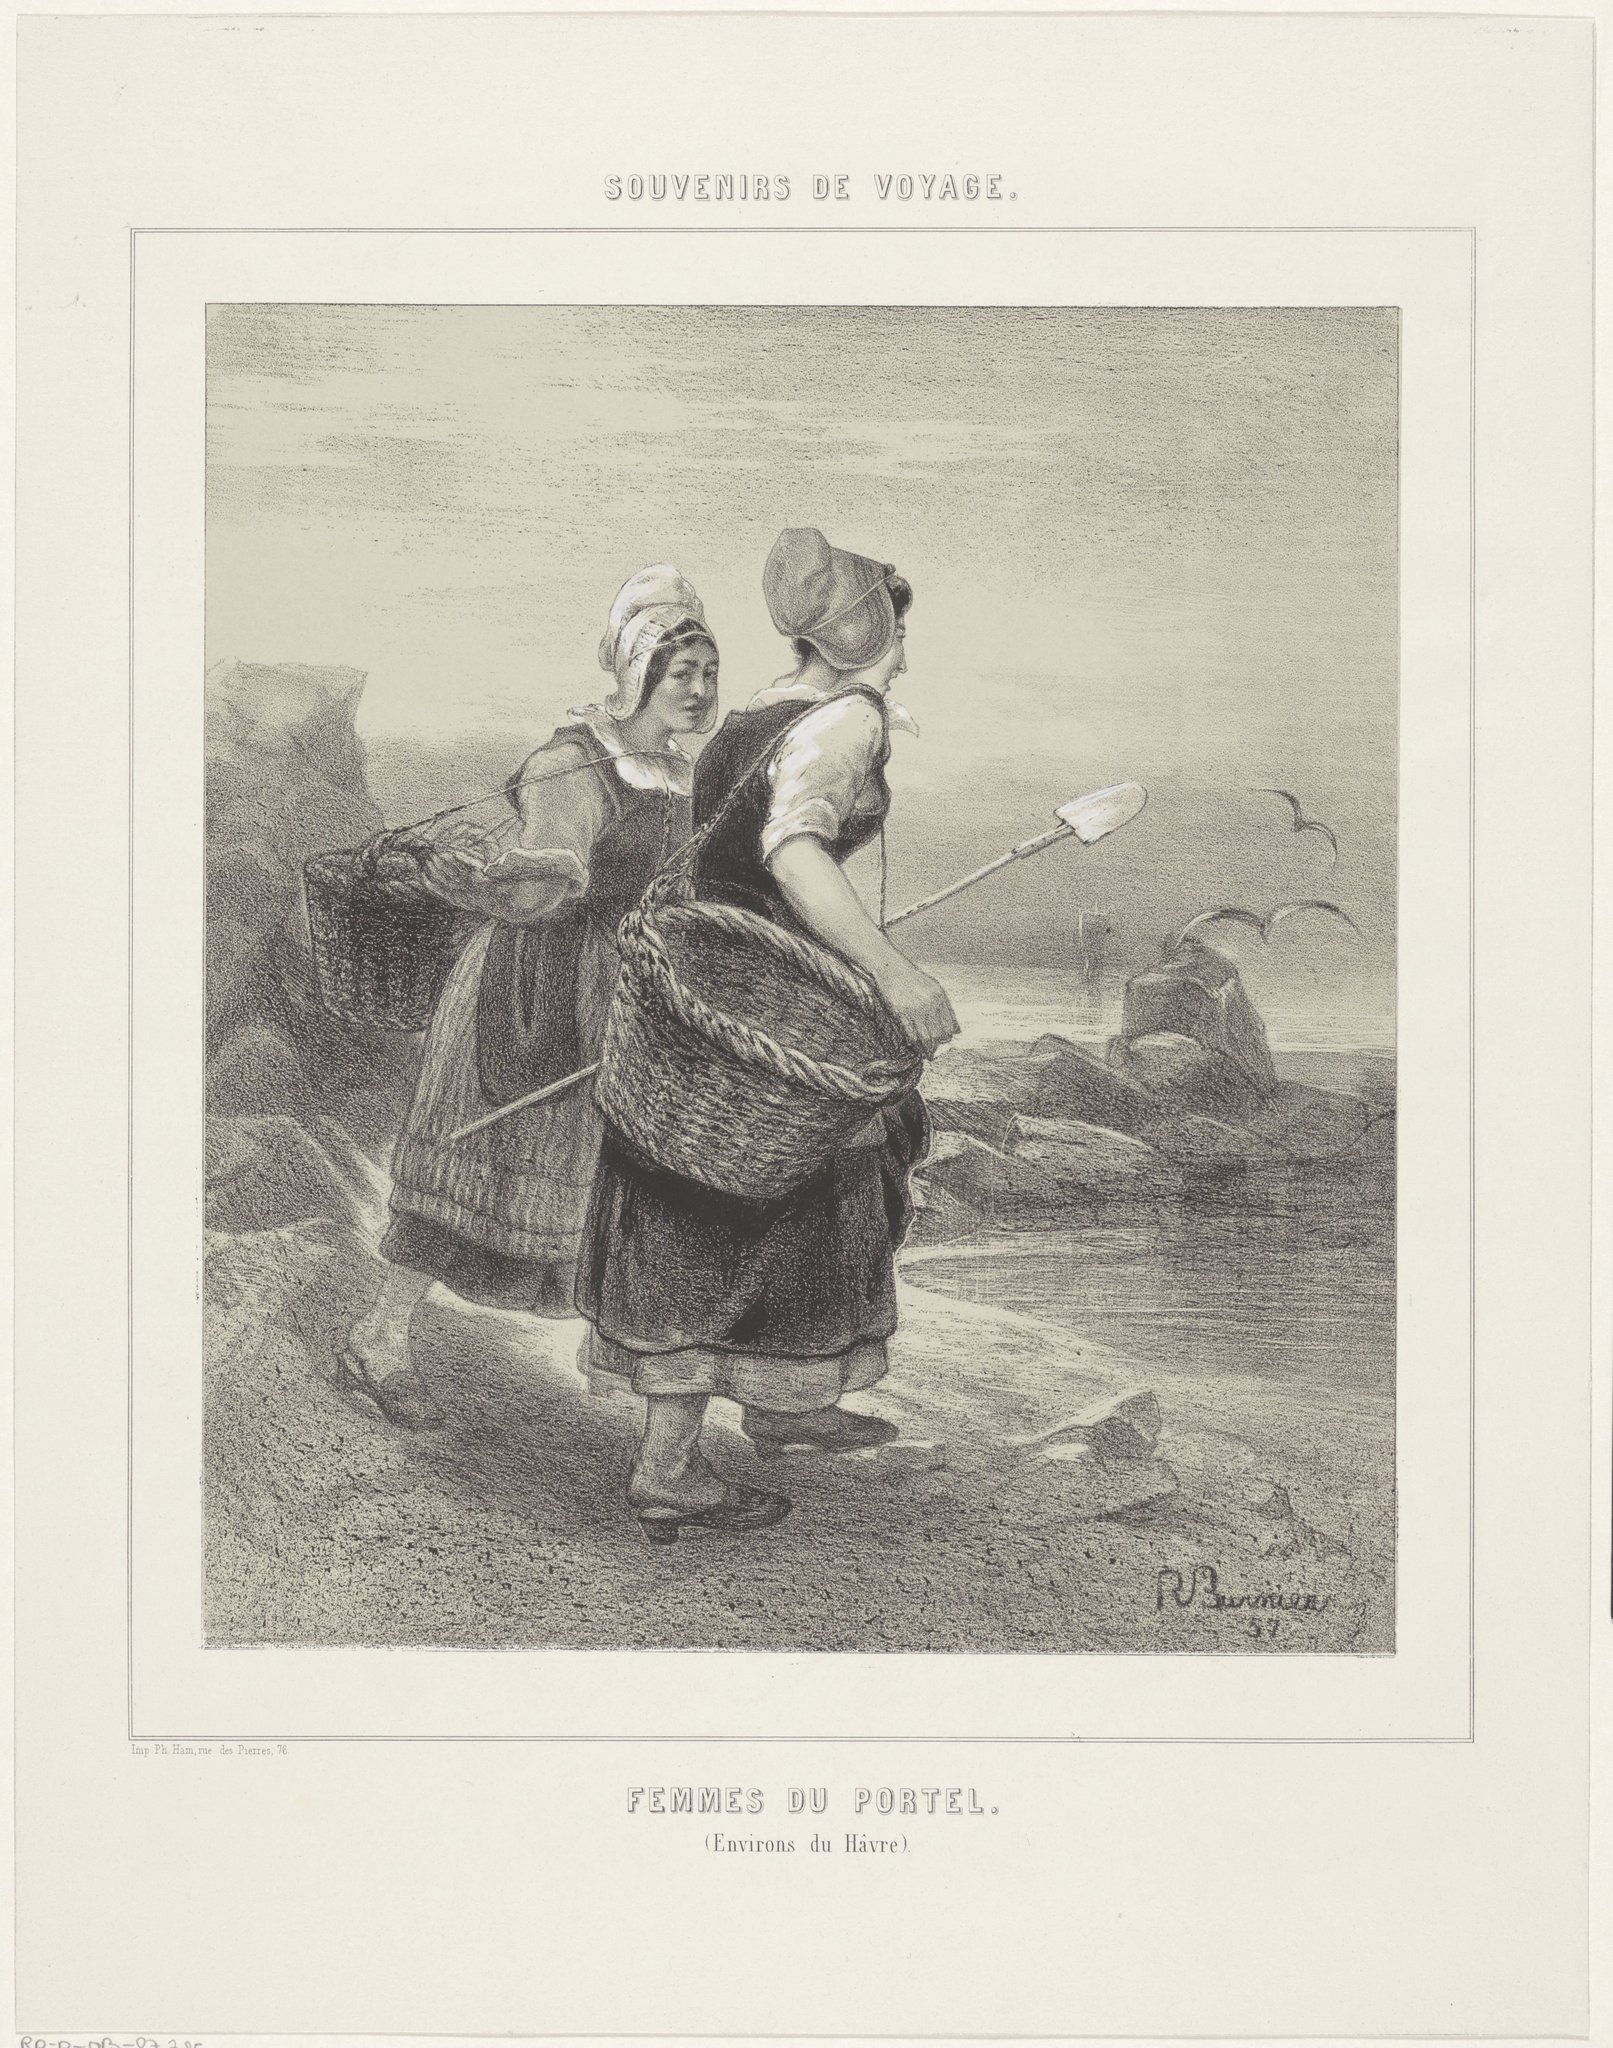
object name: print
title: Twee vrouwen op het strand van Portel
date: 1857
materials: paper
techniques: brush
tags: carrying something in basket, bag, rucksack, etc. (+ two persons ~ traffic and transport), rocky coast, agricultural implements: spade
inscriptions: collector's mark: Lugt 2228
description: De twee vrouwen dragen beiden een grote rieten mand om hun schouders. Een van hen heeft ook een spade bij zich. Ze lopen langs het water tussen rotspartijen. In de verte op het water ligt een boot met gestreken zeil.